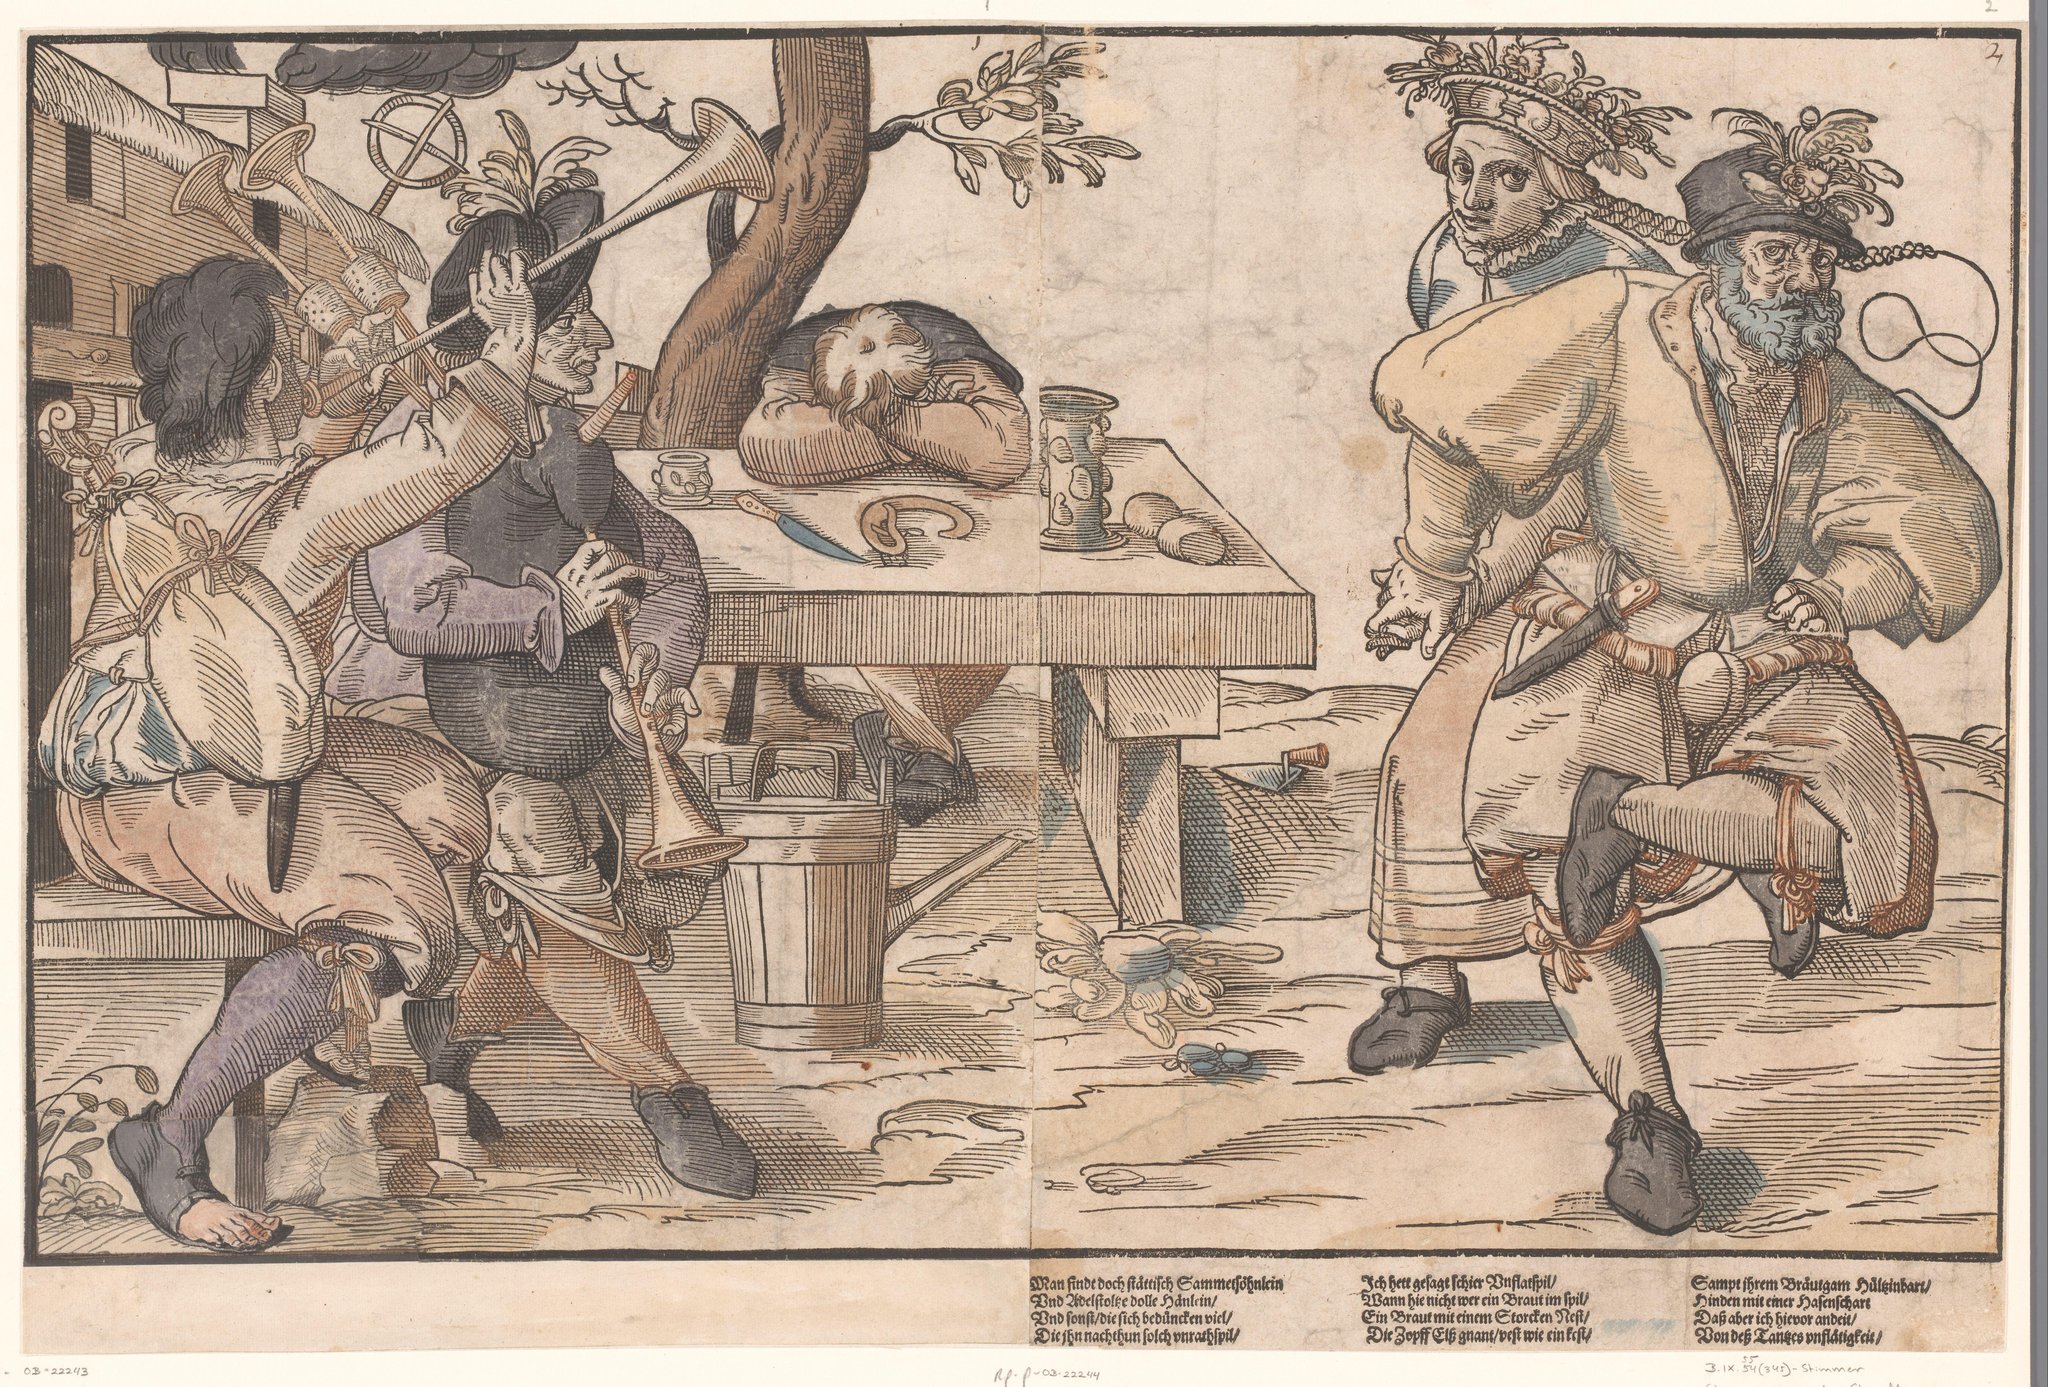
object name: print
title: Peasant Wedding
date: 1590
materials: paper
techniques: woodcut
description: Peasant weddings were a popular theme in 16th-century printmaking. They often show the bride, with a crown on her head amidst wedding guests lavishly partaking of food, drink and dancing. Next to the newly marriedcouple are two musicians playing the bagpipe and shawm. Both instruments are loud and thus ideally suited for outdoor dance music.